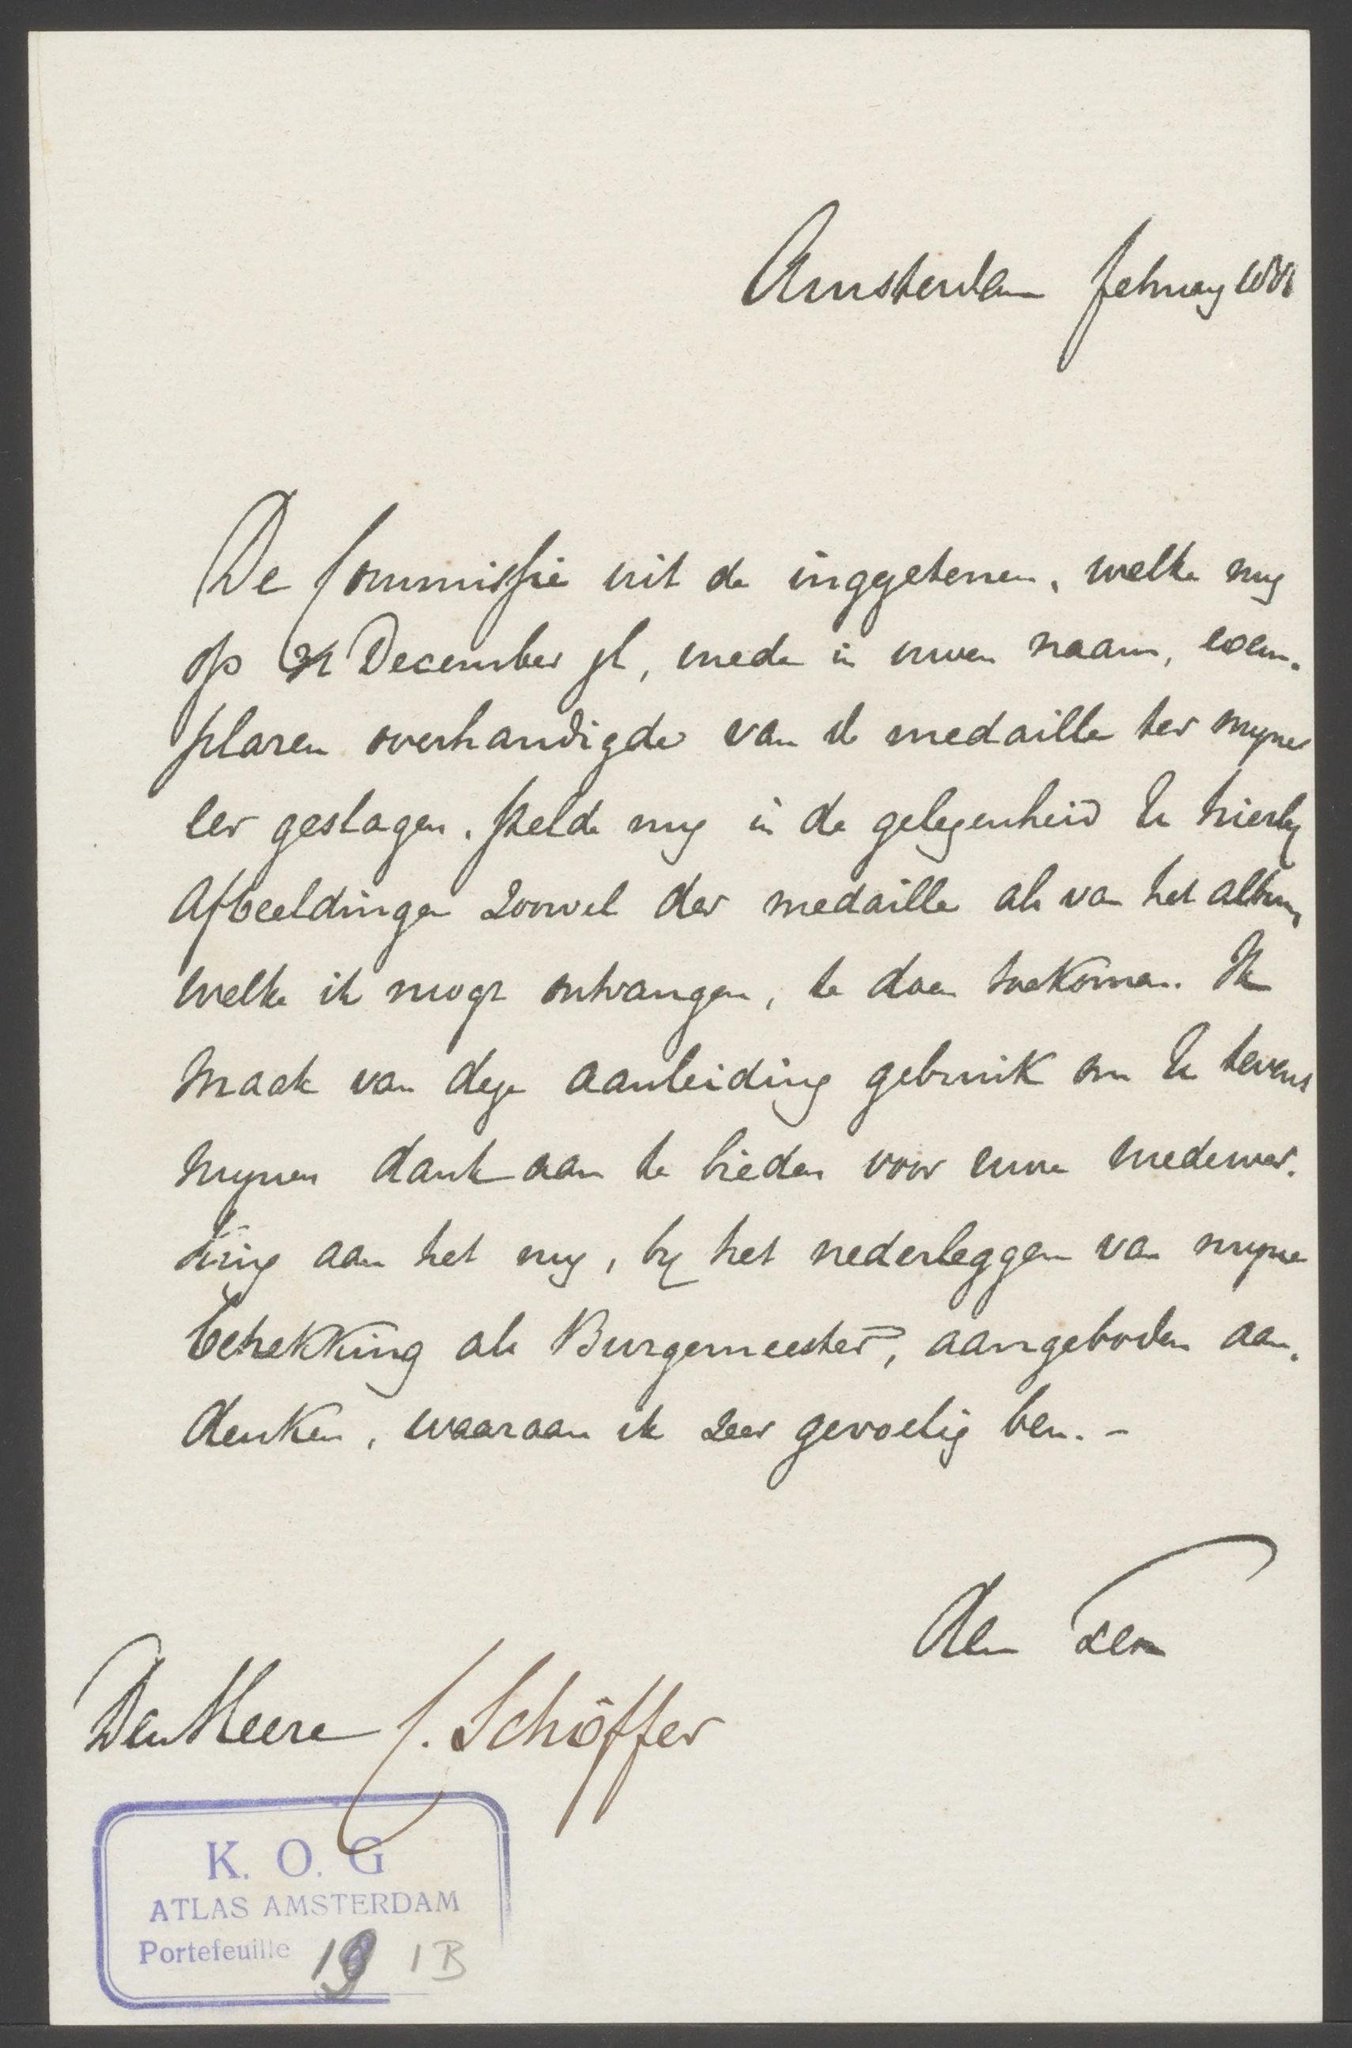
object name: text sheet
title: Brief van C. Schöffer aangaande de objecten in de omslag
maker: c. schöffer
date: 1802-1881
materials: ink, paper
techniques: pen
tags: handwriting, written text, amsterdam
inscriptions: collector's mark: ‘19 1B’ Lugt 1641b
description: Onderwerpsrubriek binnen de Atlas Amsterdam: Herinneringen aan regeringsleden en hunne huisgezinnen [na 1800].